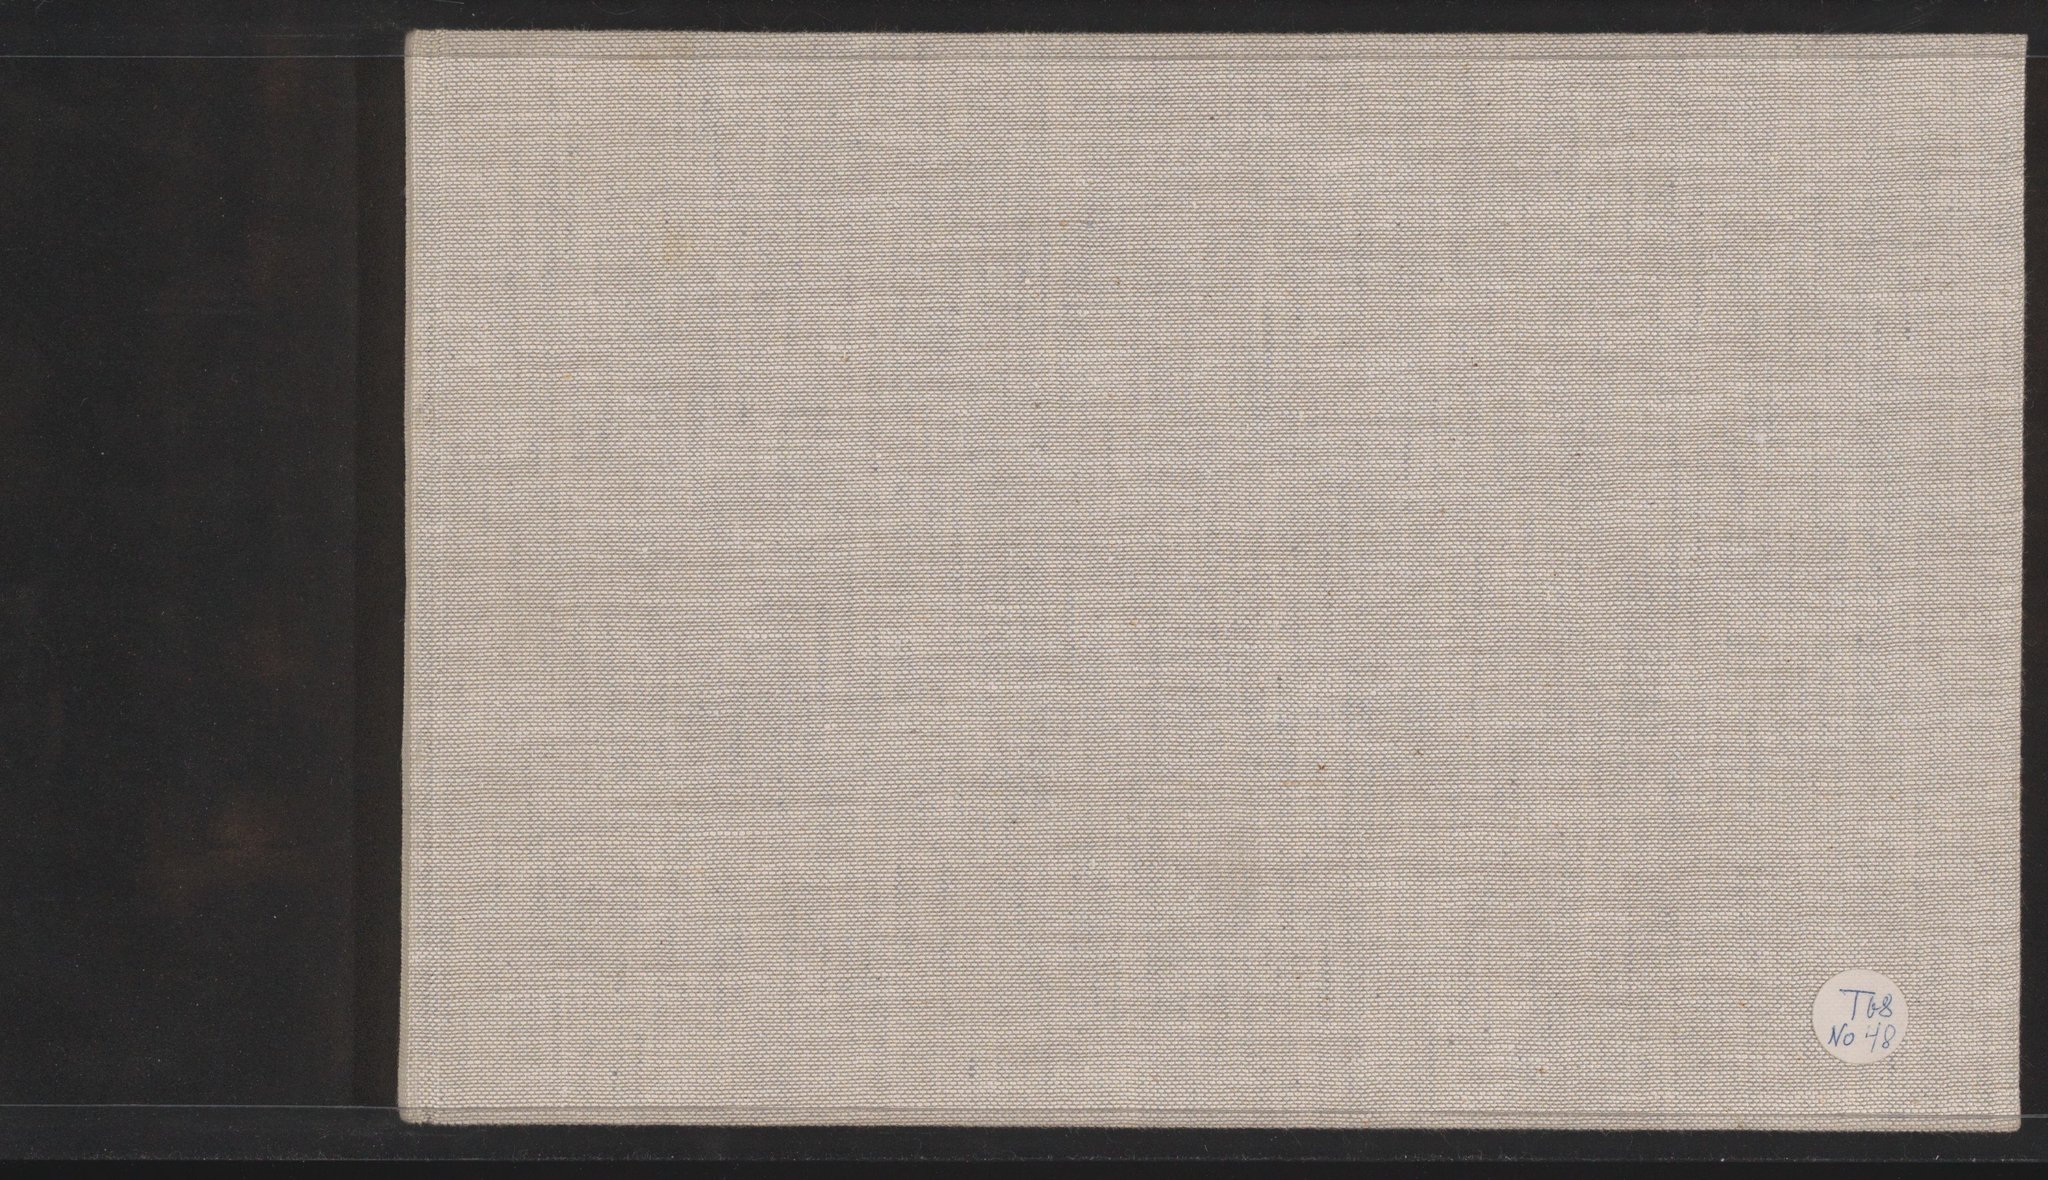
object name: sketchbook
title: Schetsboek met 30 bladen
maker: jozef israëls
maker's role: draughtsman, painter, print maker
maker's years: 1824-1911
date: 1834-1911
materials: cardboard, chalk, linen, paper, pencil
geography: veenendaal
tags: child, farmers, artist at work, in his workshop - bb - out of doors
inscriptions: collector's mark: Lugt 2228a, label: ‘T68/ No 48’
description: Schetsboek bestaande uit 30 bladen met figuren, voornamelijk vrouwen, kinderen en arbeiders. Tevens enkele dieren, landschappen en kunstenaars die in de open lucht werken.